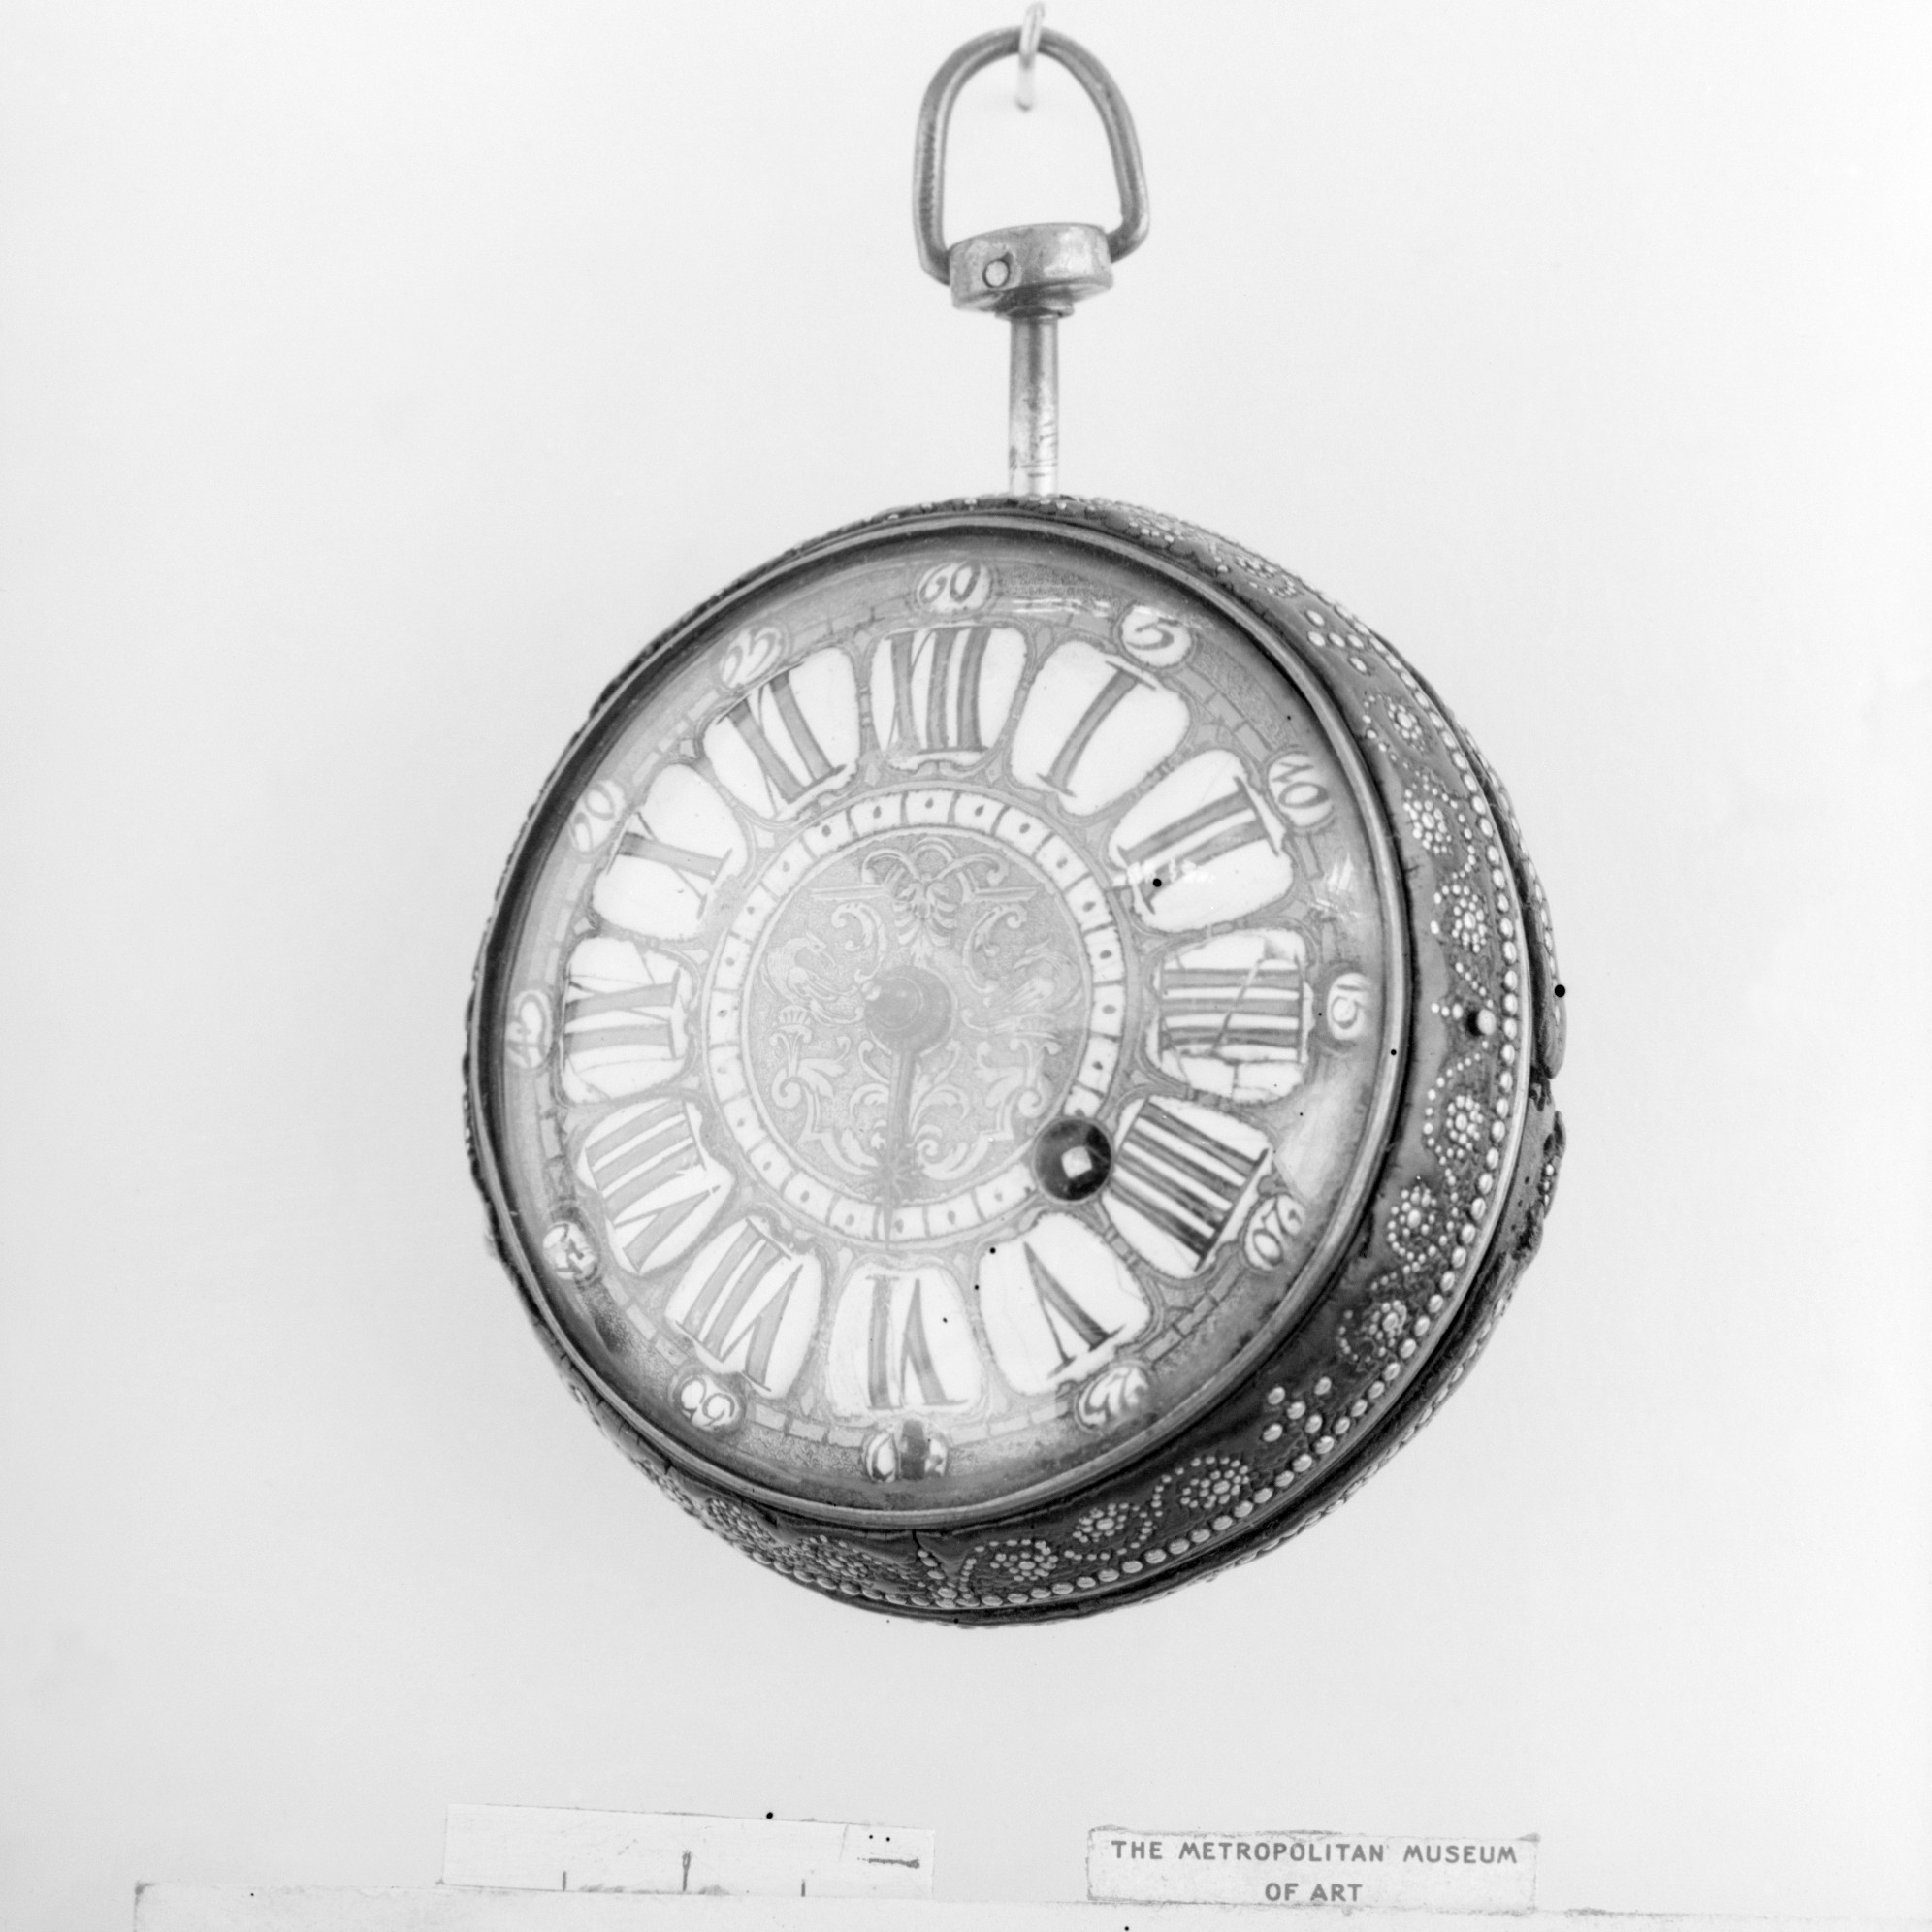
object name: clock watch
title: Clock-watch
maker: leonardus quesi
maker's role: maker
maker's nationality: french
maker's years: 1650-1750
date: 1700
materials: enamel, gold, leather, metal